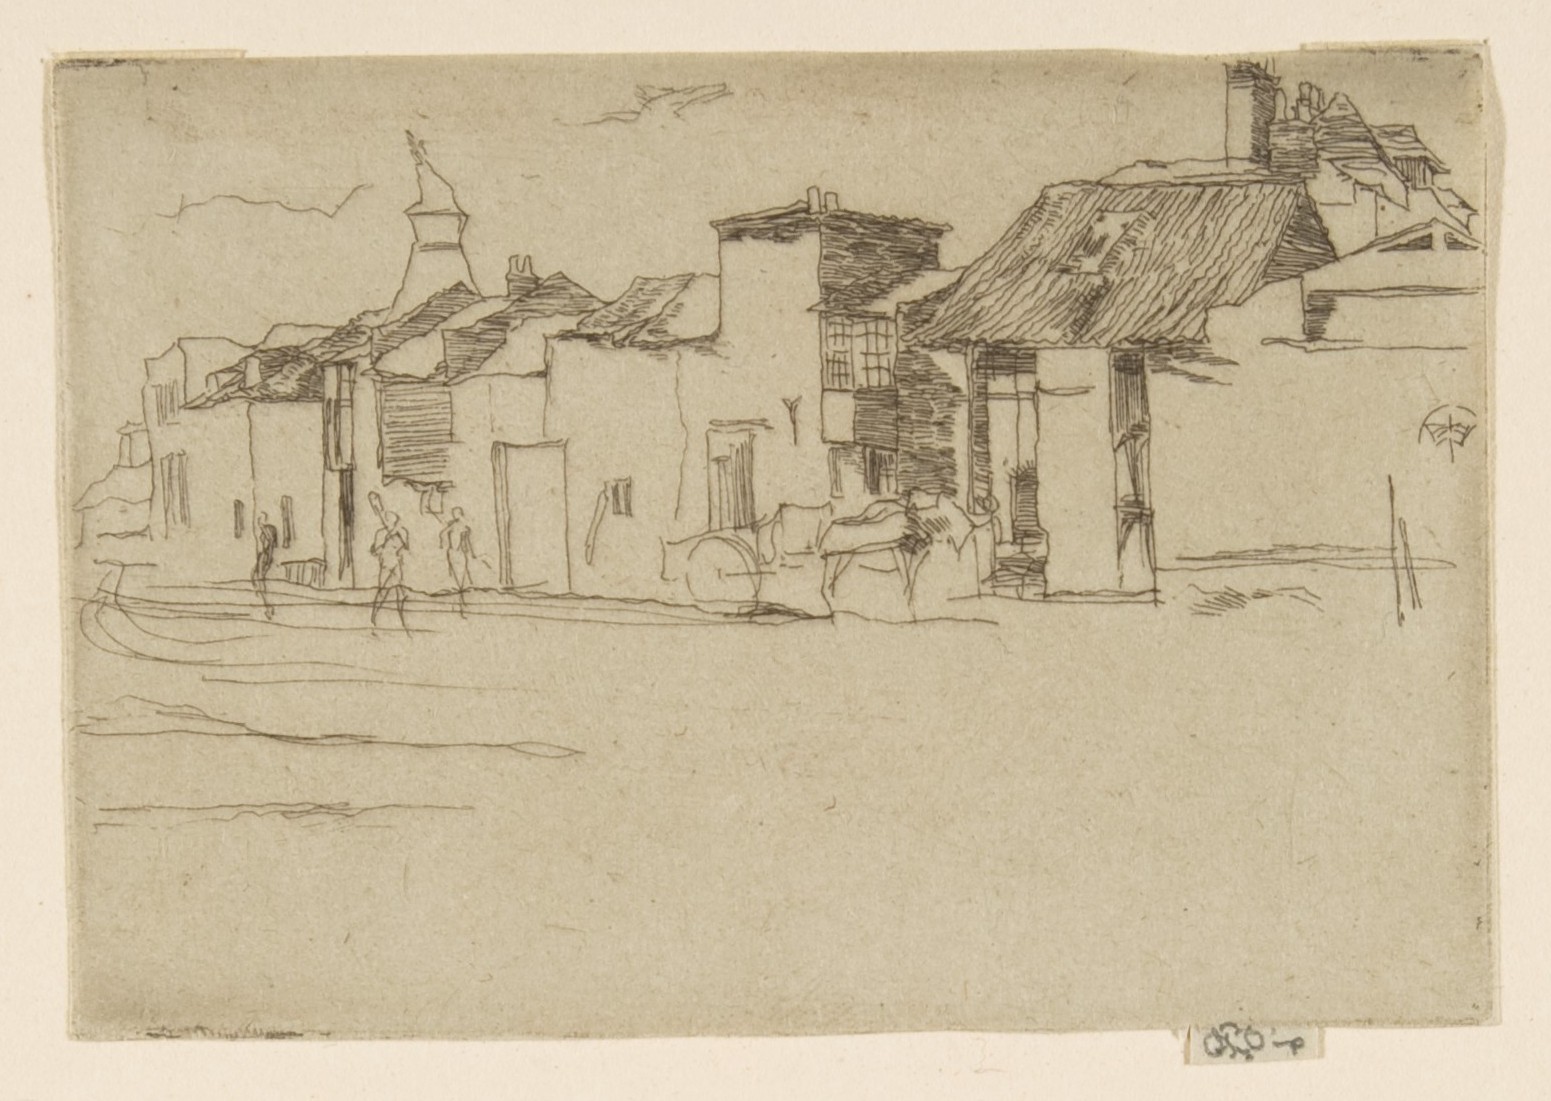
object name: print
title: "The Swan," Chelsea (The Old Swan Brewery, Chelsea)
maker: james mcneill whistler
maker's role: artist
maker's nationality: american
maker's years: 1834-1903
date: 1872-1873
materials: ink, paper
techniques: etching, printing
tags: buildings,london